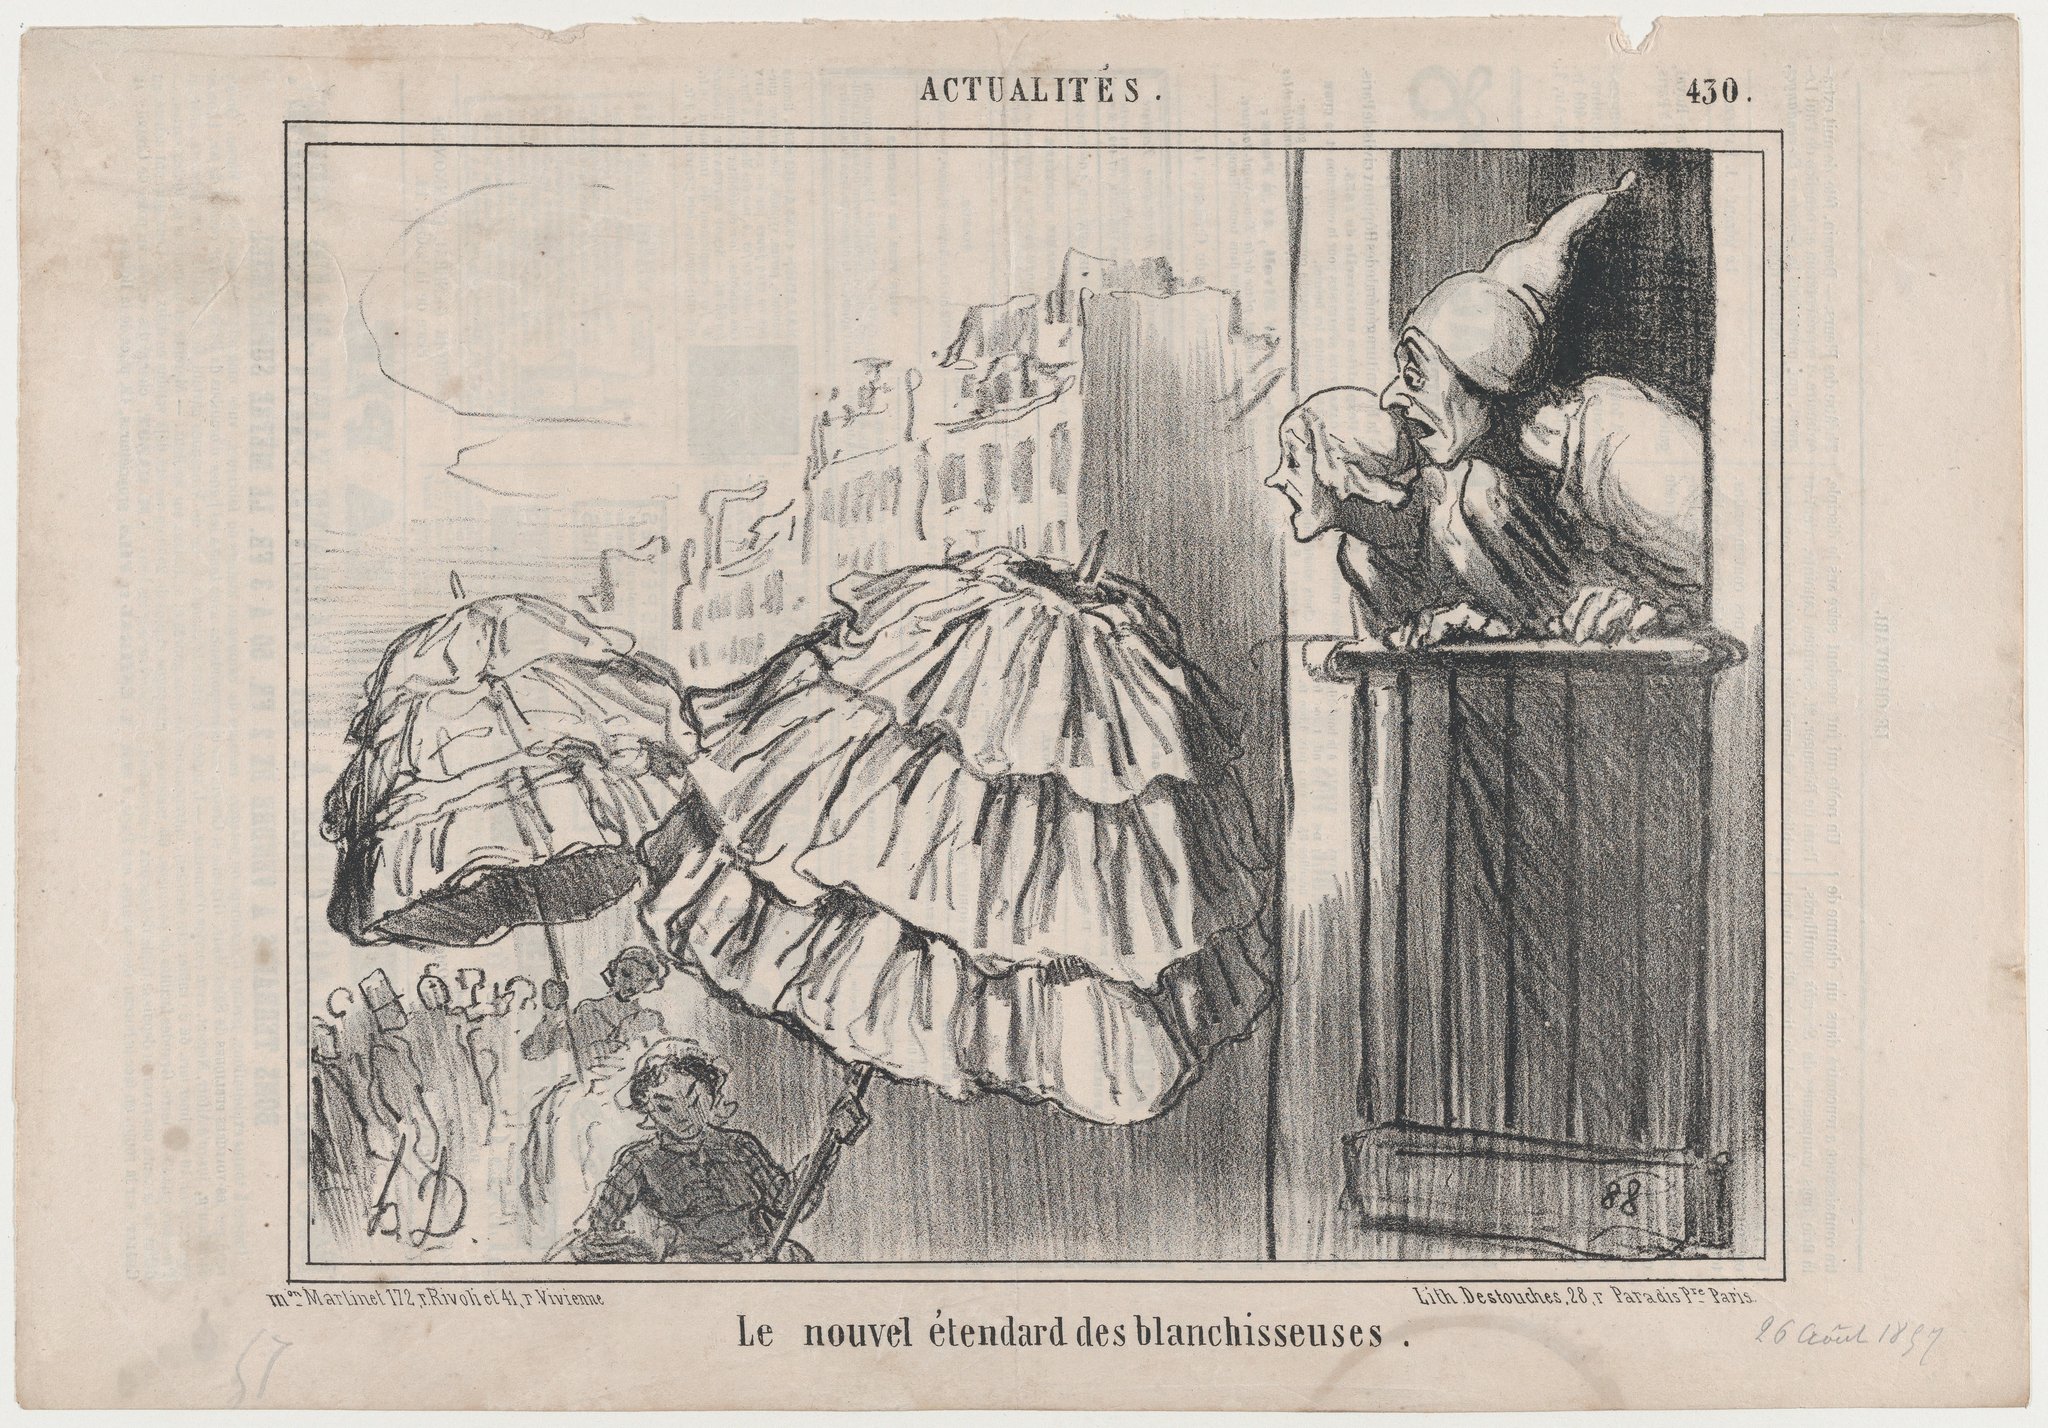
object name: print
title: Le nouvel étendard des blanchisseuses, from Actualités, published in Le Charivari, August 26, 1857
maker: honoré daumier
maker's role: artist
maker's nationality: french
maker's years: 1808-1879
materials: paper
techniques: lithograph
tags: satire,women